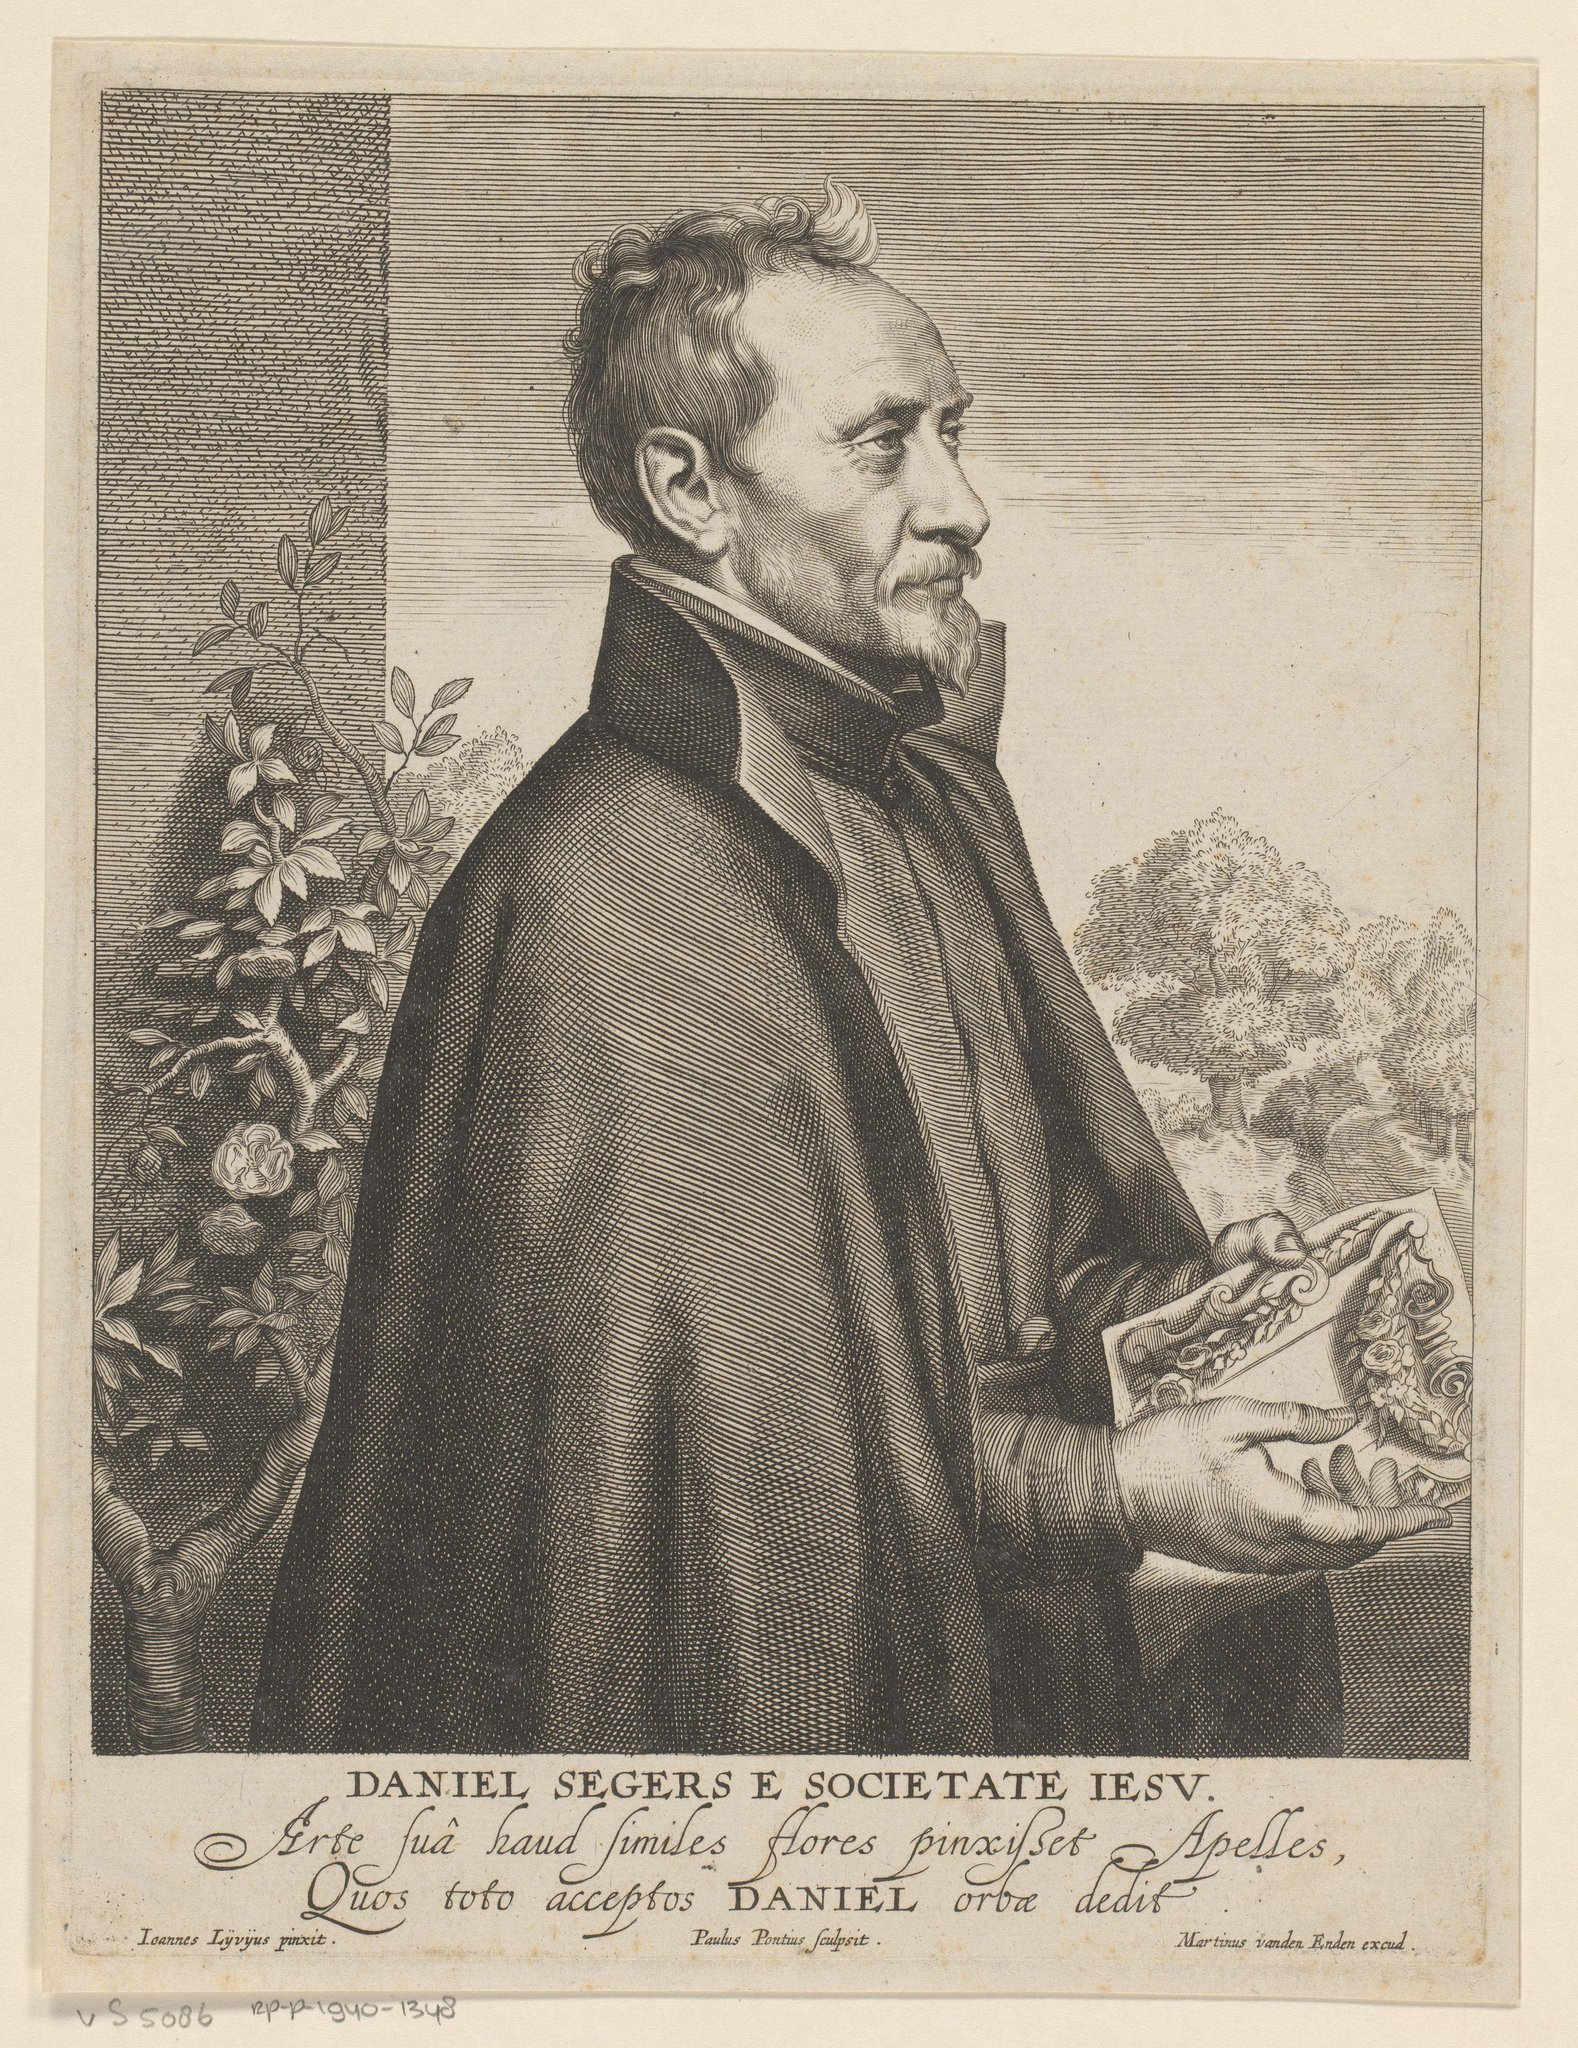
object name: print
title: Portret van Daniël Seghers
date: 1630-1654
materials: paper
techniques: engraving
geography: antwerp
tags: antwerp, painter, historical persons, portrait, self-portrait of artist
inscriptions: collector's mark: Lugt 2228, collector's mark: Lugt 2760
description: Met drieregelig onderschrift in het Latijn.